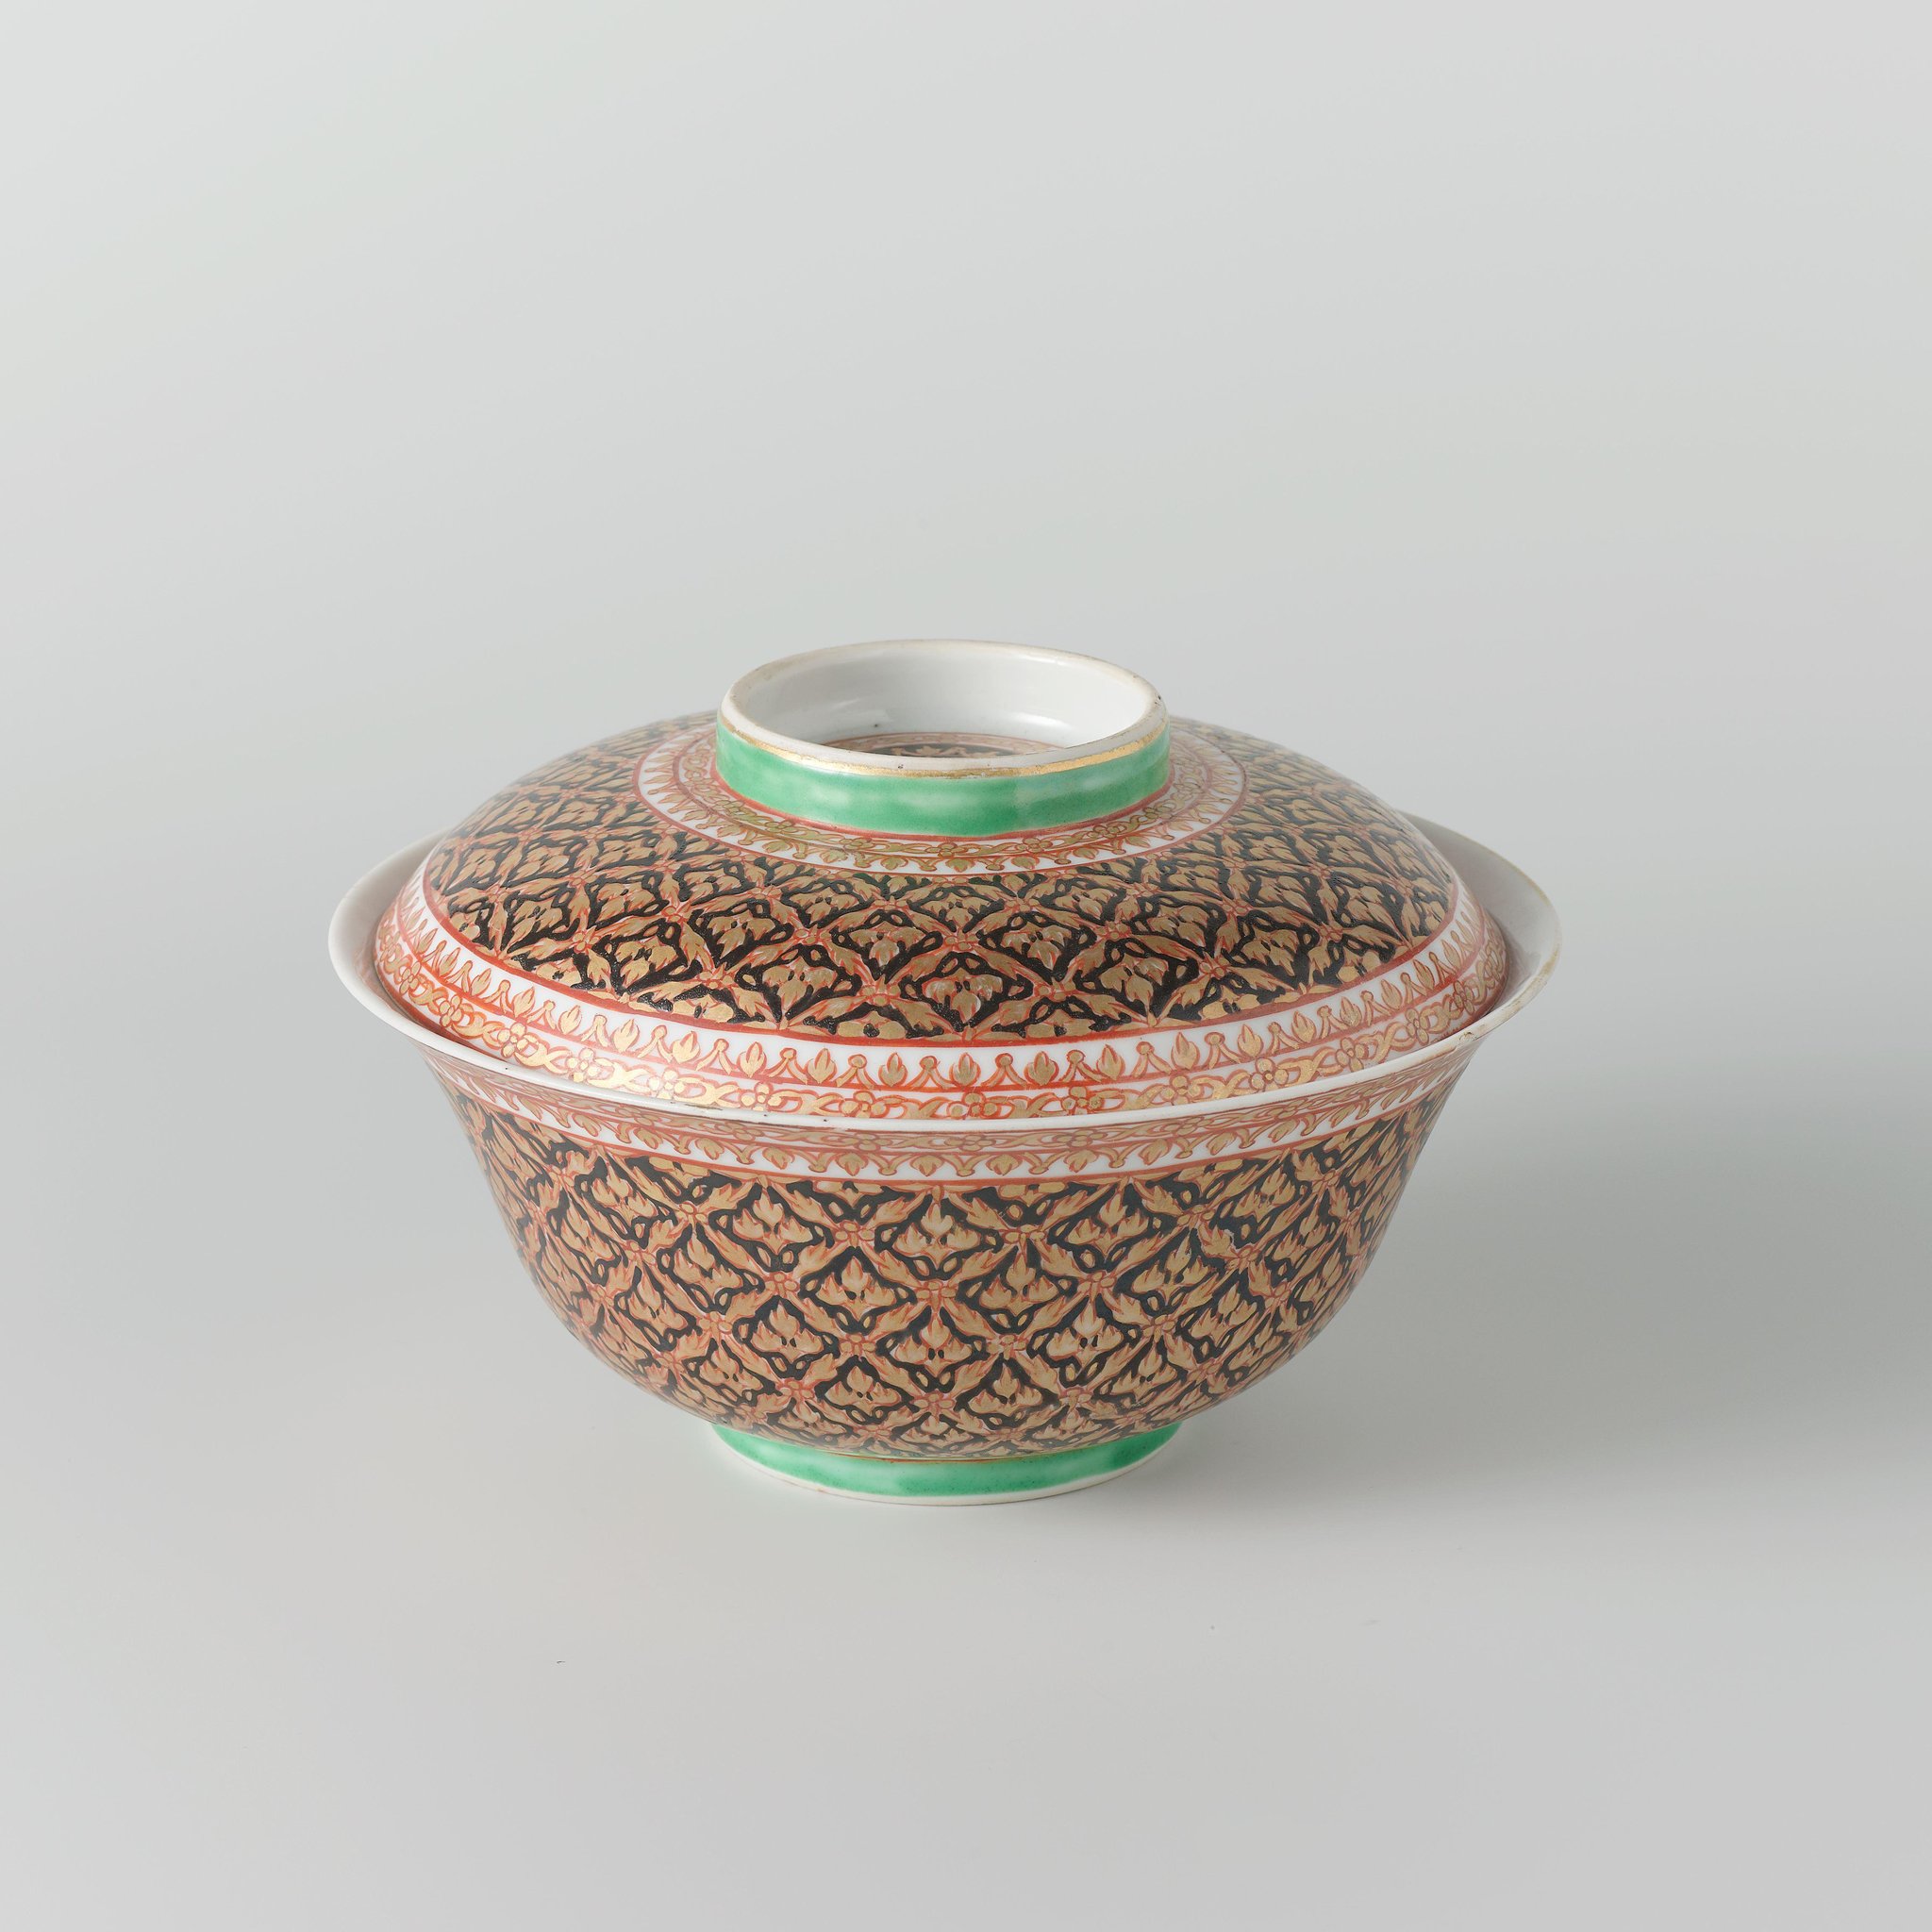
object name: covered bowl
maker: Anonymous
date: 1800-1899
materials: glaze, gold, paint, porcelain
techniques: firing, gilding, turning, vitrification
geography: china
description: Klokvormige dekselkom van porselein, beschilderd op het glazuur in rood, groen, zwart en goud. De wand is bedekt met een geometrisch bladpatroon; op de rand een decoratieve band. De voetring is groen. Exportgoed voor Thailand in de Bencharong-stijl (vijf kleuren). Porselein met emailkleuren.